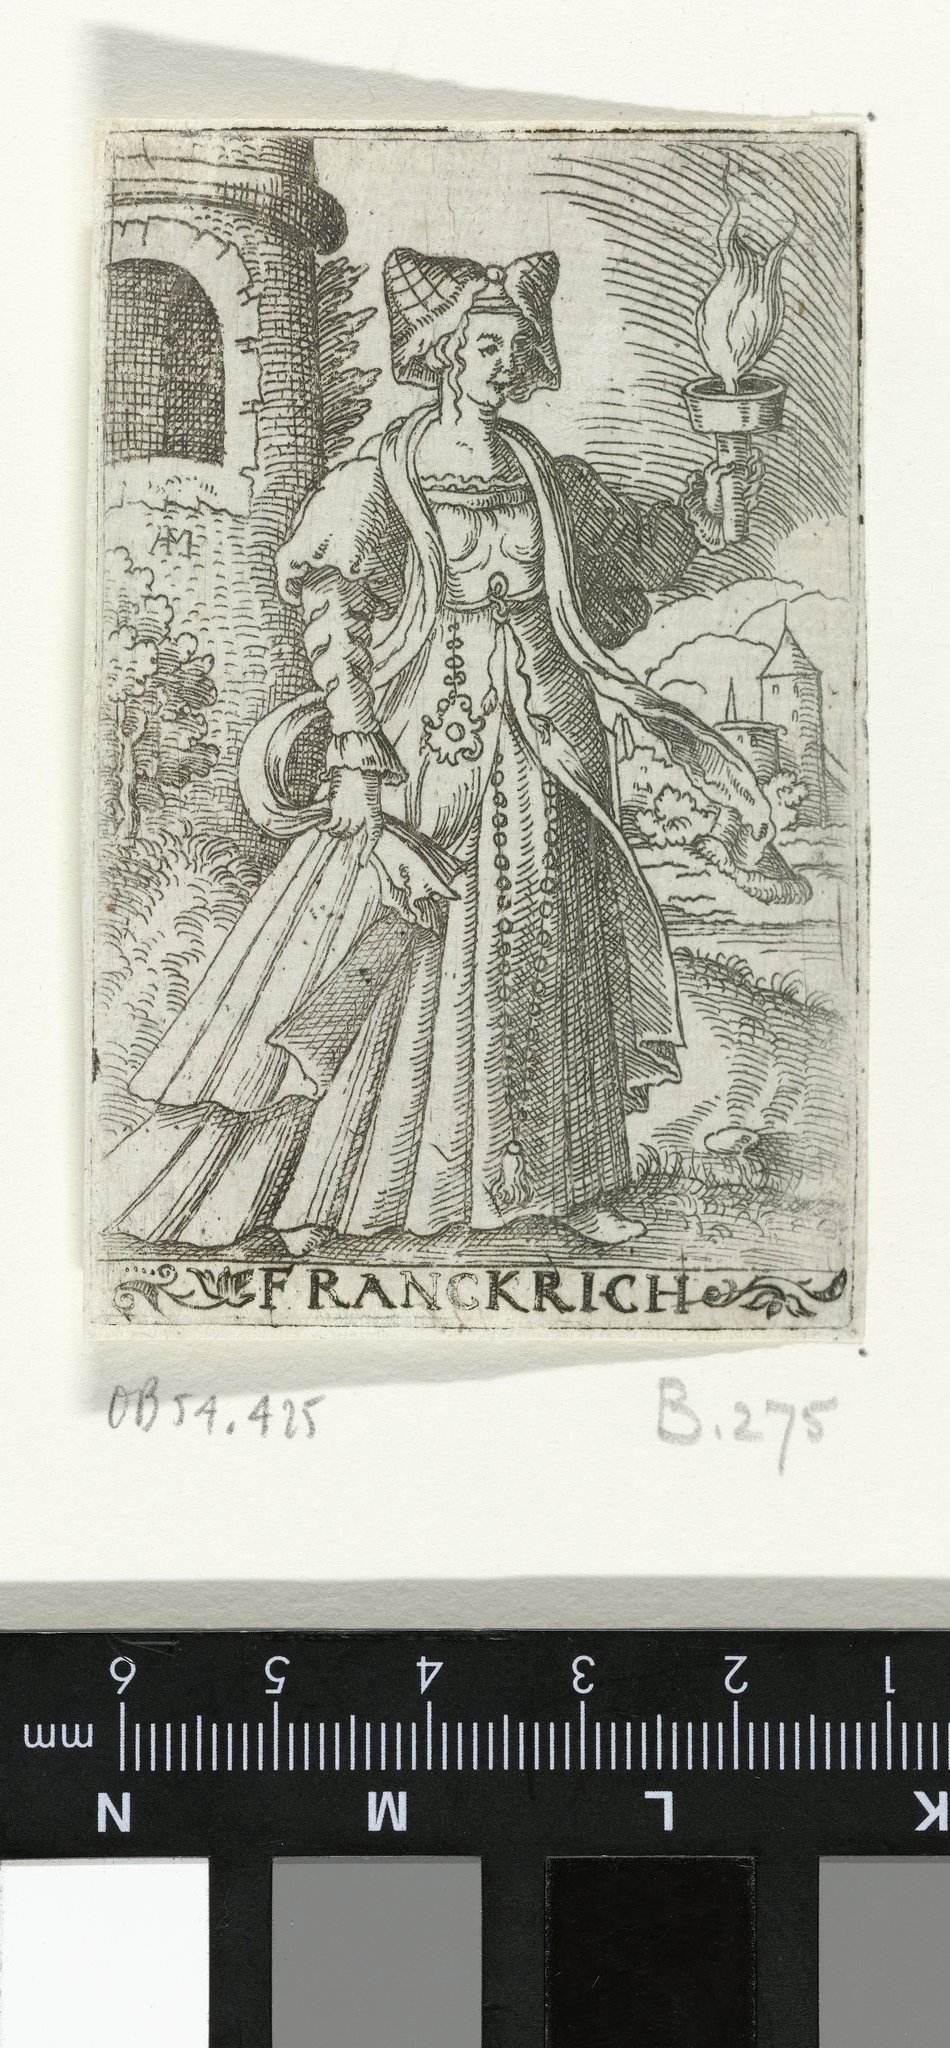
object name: print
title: Franckrich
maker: virgilius solis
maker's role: draughtsman, print maker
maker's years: 1514-1562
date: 1524-1562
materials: paper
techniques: engraving, etching, intaglio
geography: nuremberg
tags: personifications of countries, nations, states, districts, etc., representation of wise virgin(s), france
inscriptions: collector's mark: Lugt 2228, number: ‘128’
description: Prent maakt deel uit van een serie van tien prenten met personificaties van Europese landen en provinciën als de vijf wijze en vijf dwaze maagden.